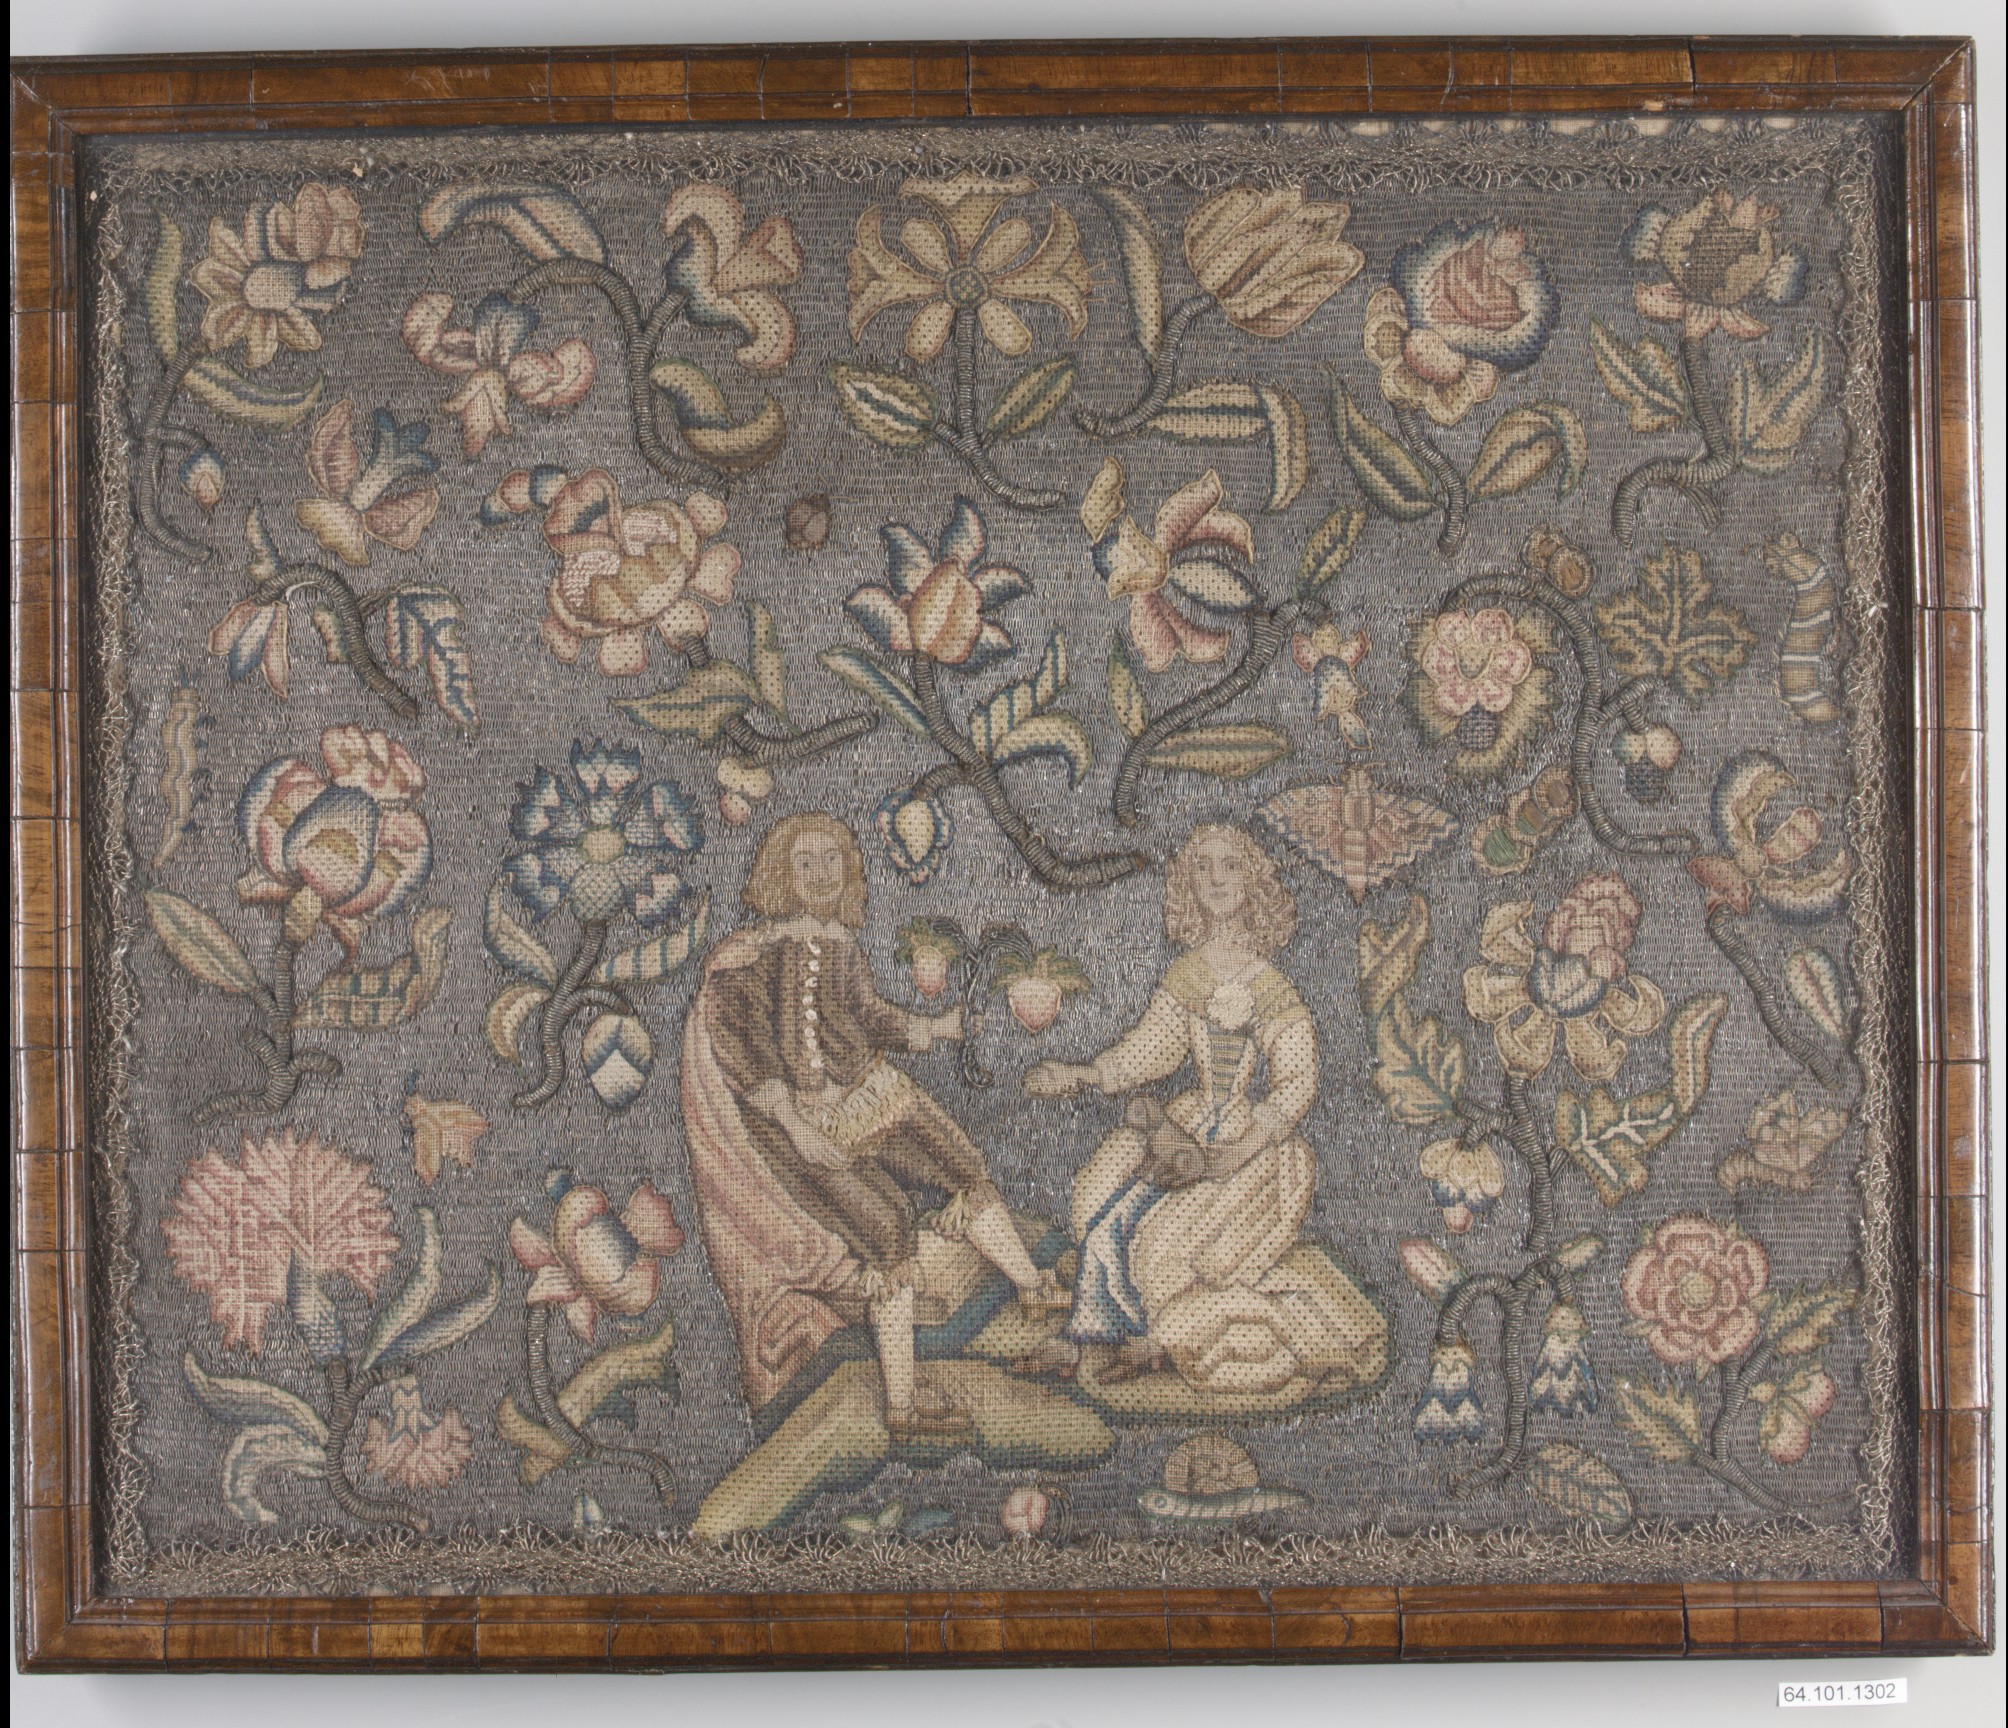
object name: embroidered picture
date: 1634-1666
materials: canvas, metal thread, silk, wool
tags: men,women,insects,snails,flowers